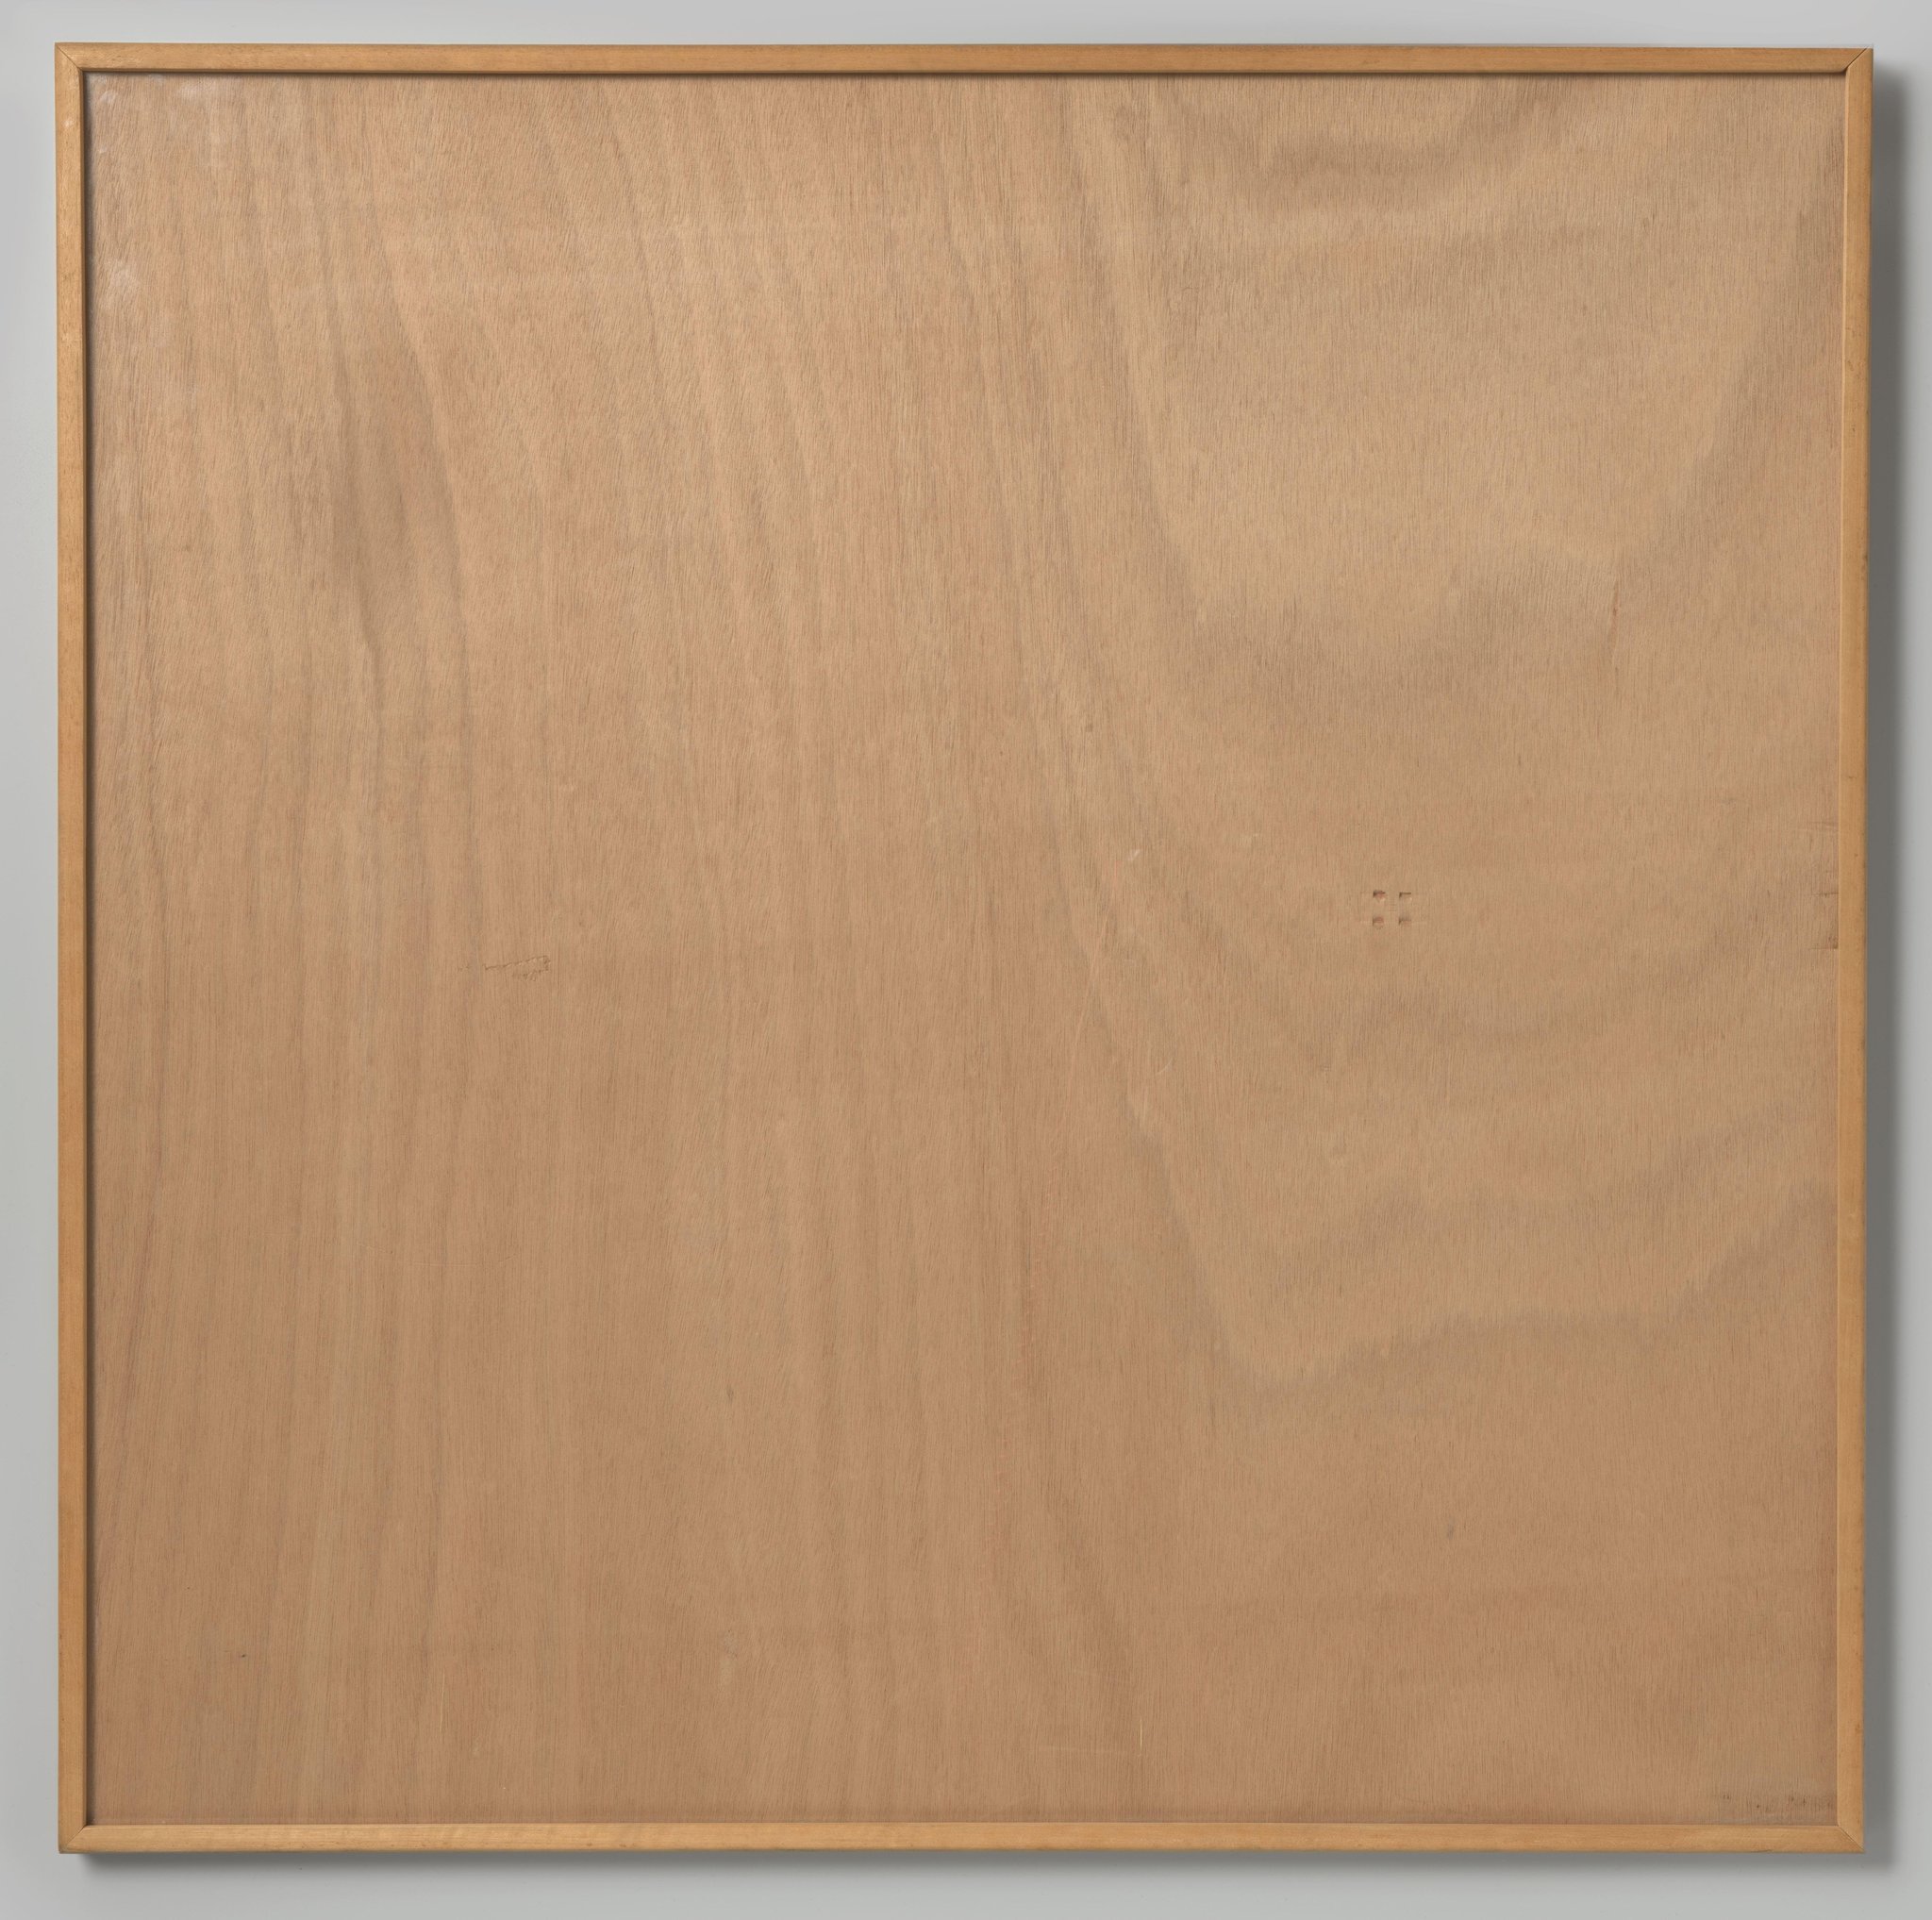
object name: frame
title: Lijst voor Field van Peter Struycken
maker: Anonymous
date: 1400-1950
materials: wood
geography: netherlands